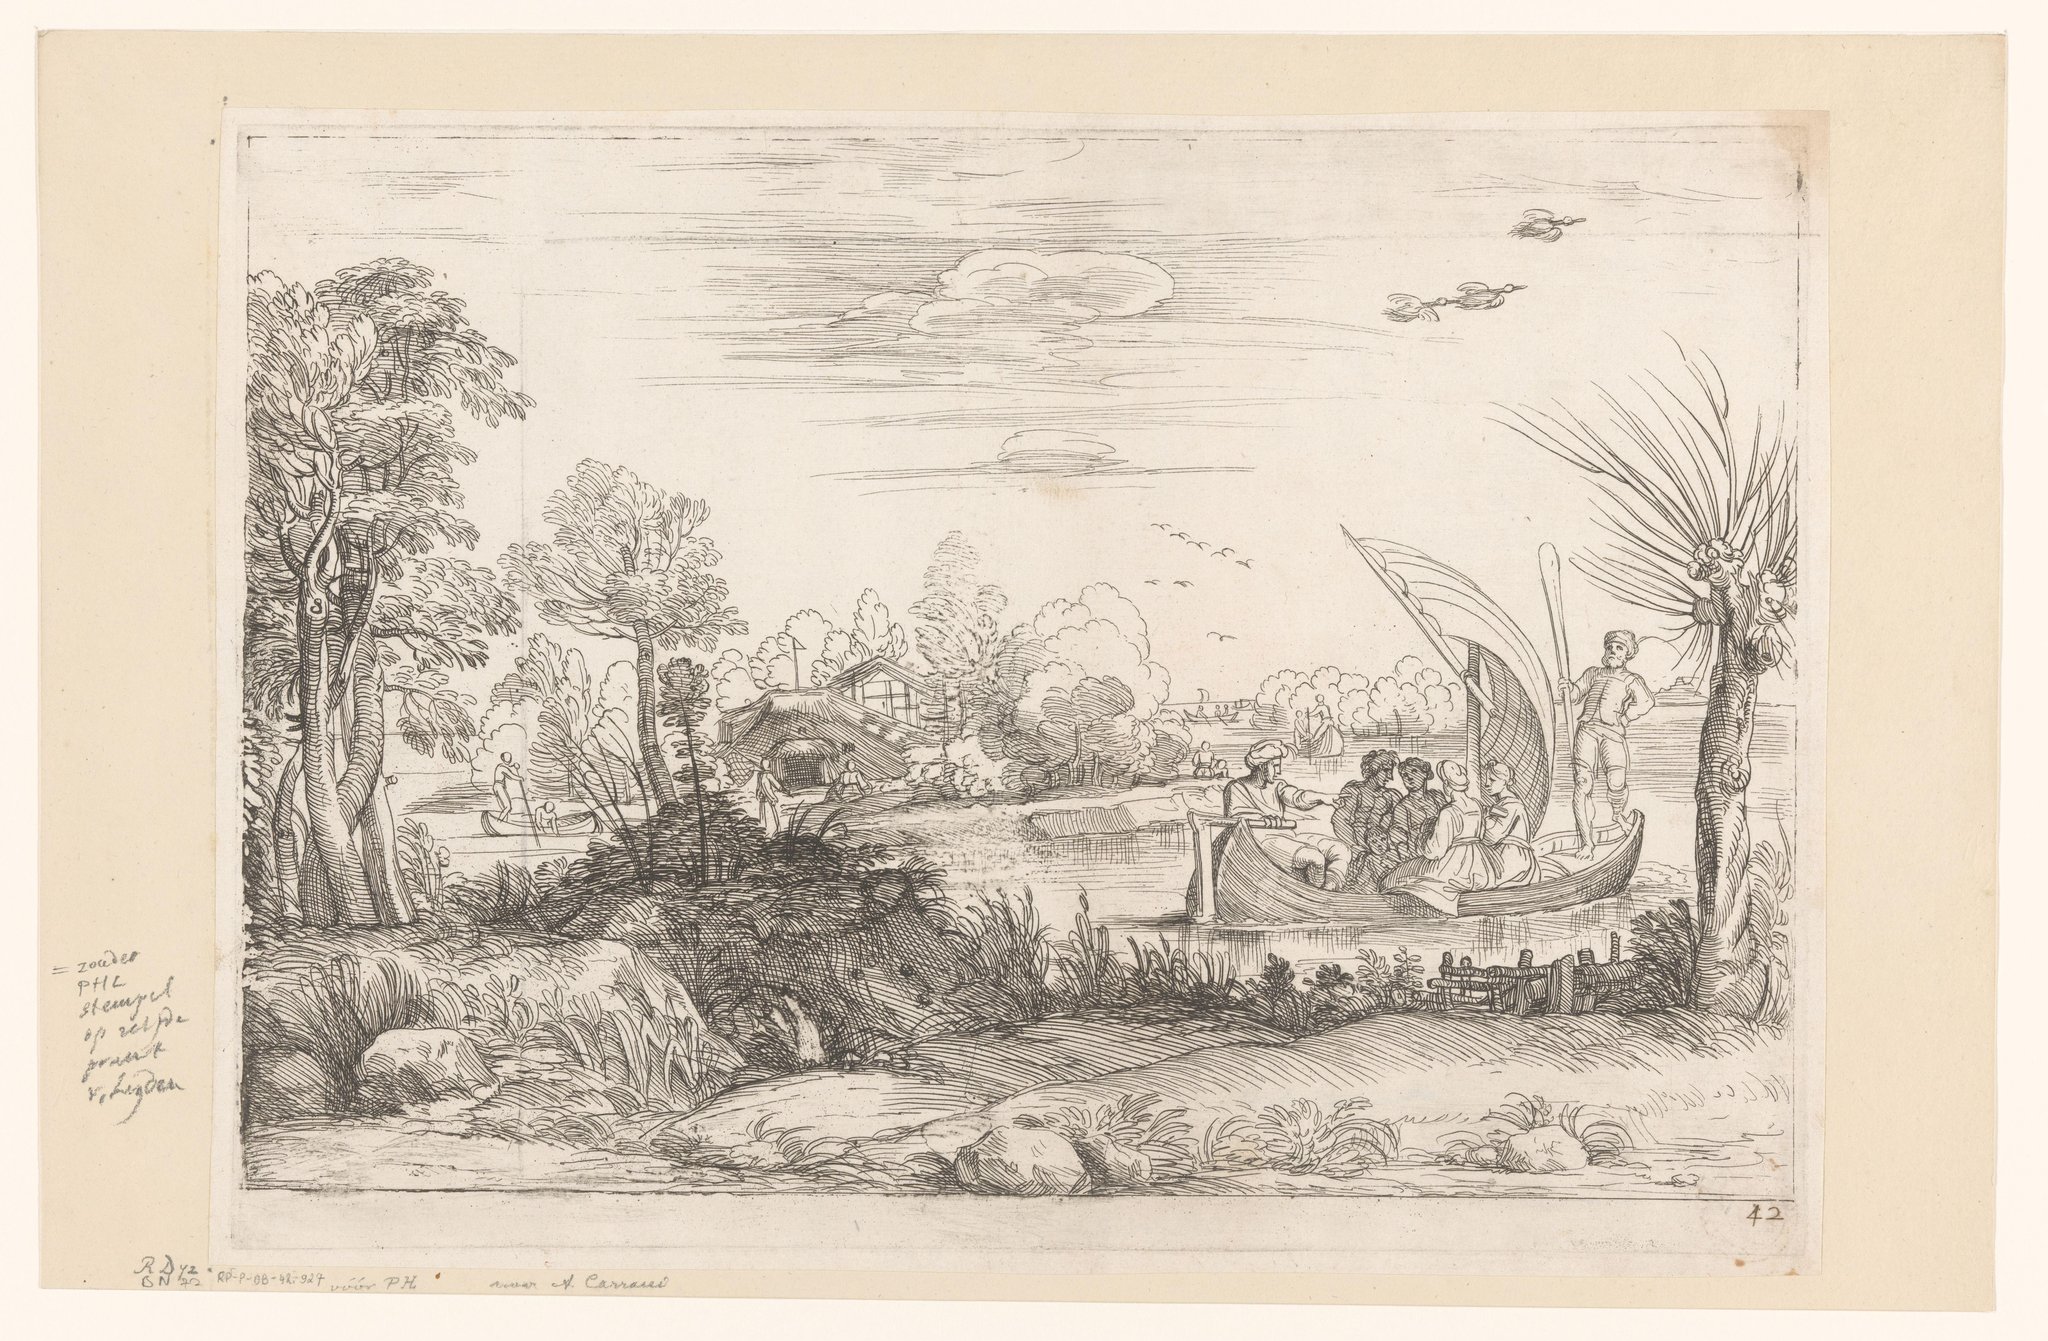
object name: print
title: Prenten naar tekeningen uit het kabinet Jabach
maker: michel corneille (ii)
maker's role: painter, print maker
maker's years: 1642-1708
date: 1652-1708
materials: paper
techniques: engraving, etching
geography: france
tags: sailing-ship, sailing-boat, landscapes with waters, waterscapes, seascapes (in the temperate zone) - hh - ideal landscapes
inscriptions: collector's mark: Lugt 240